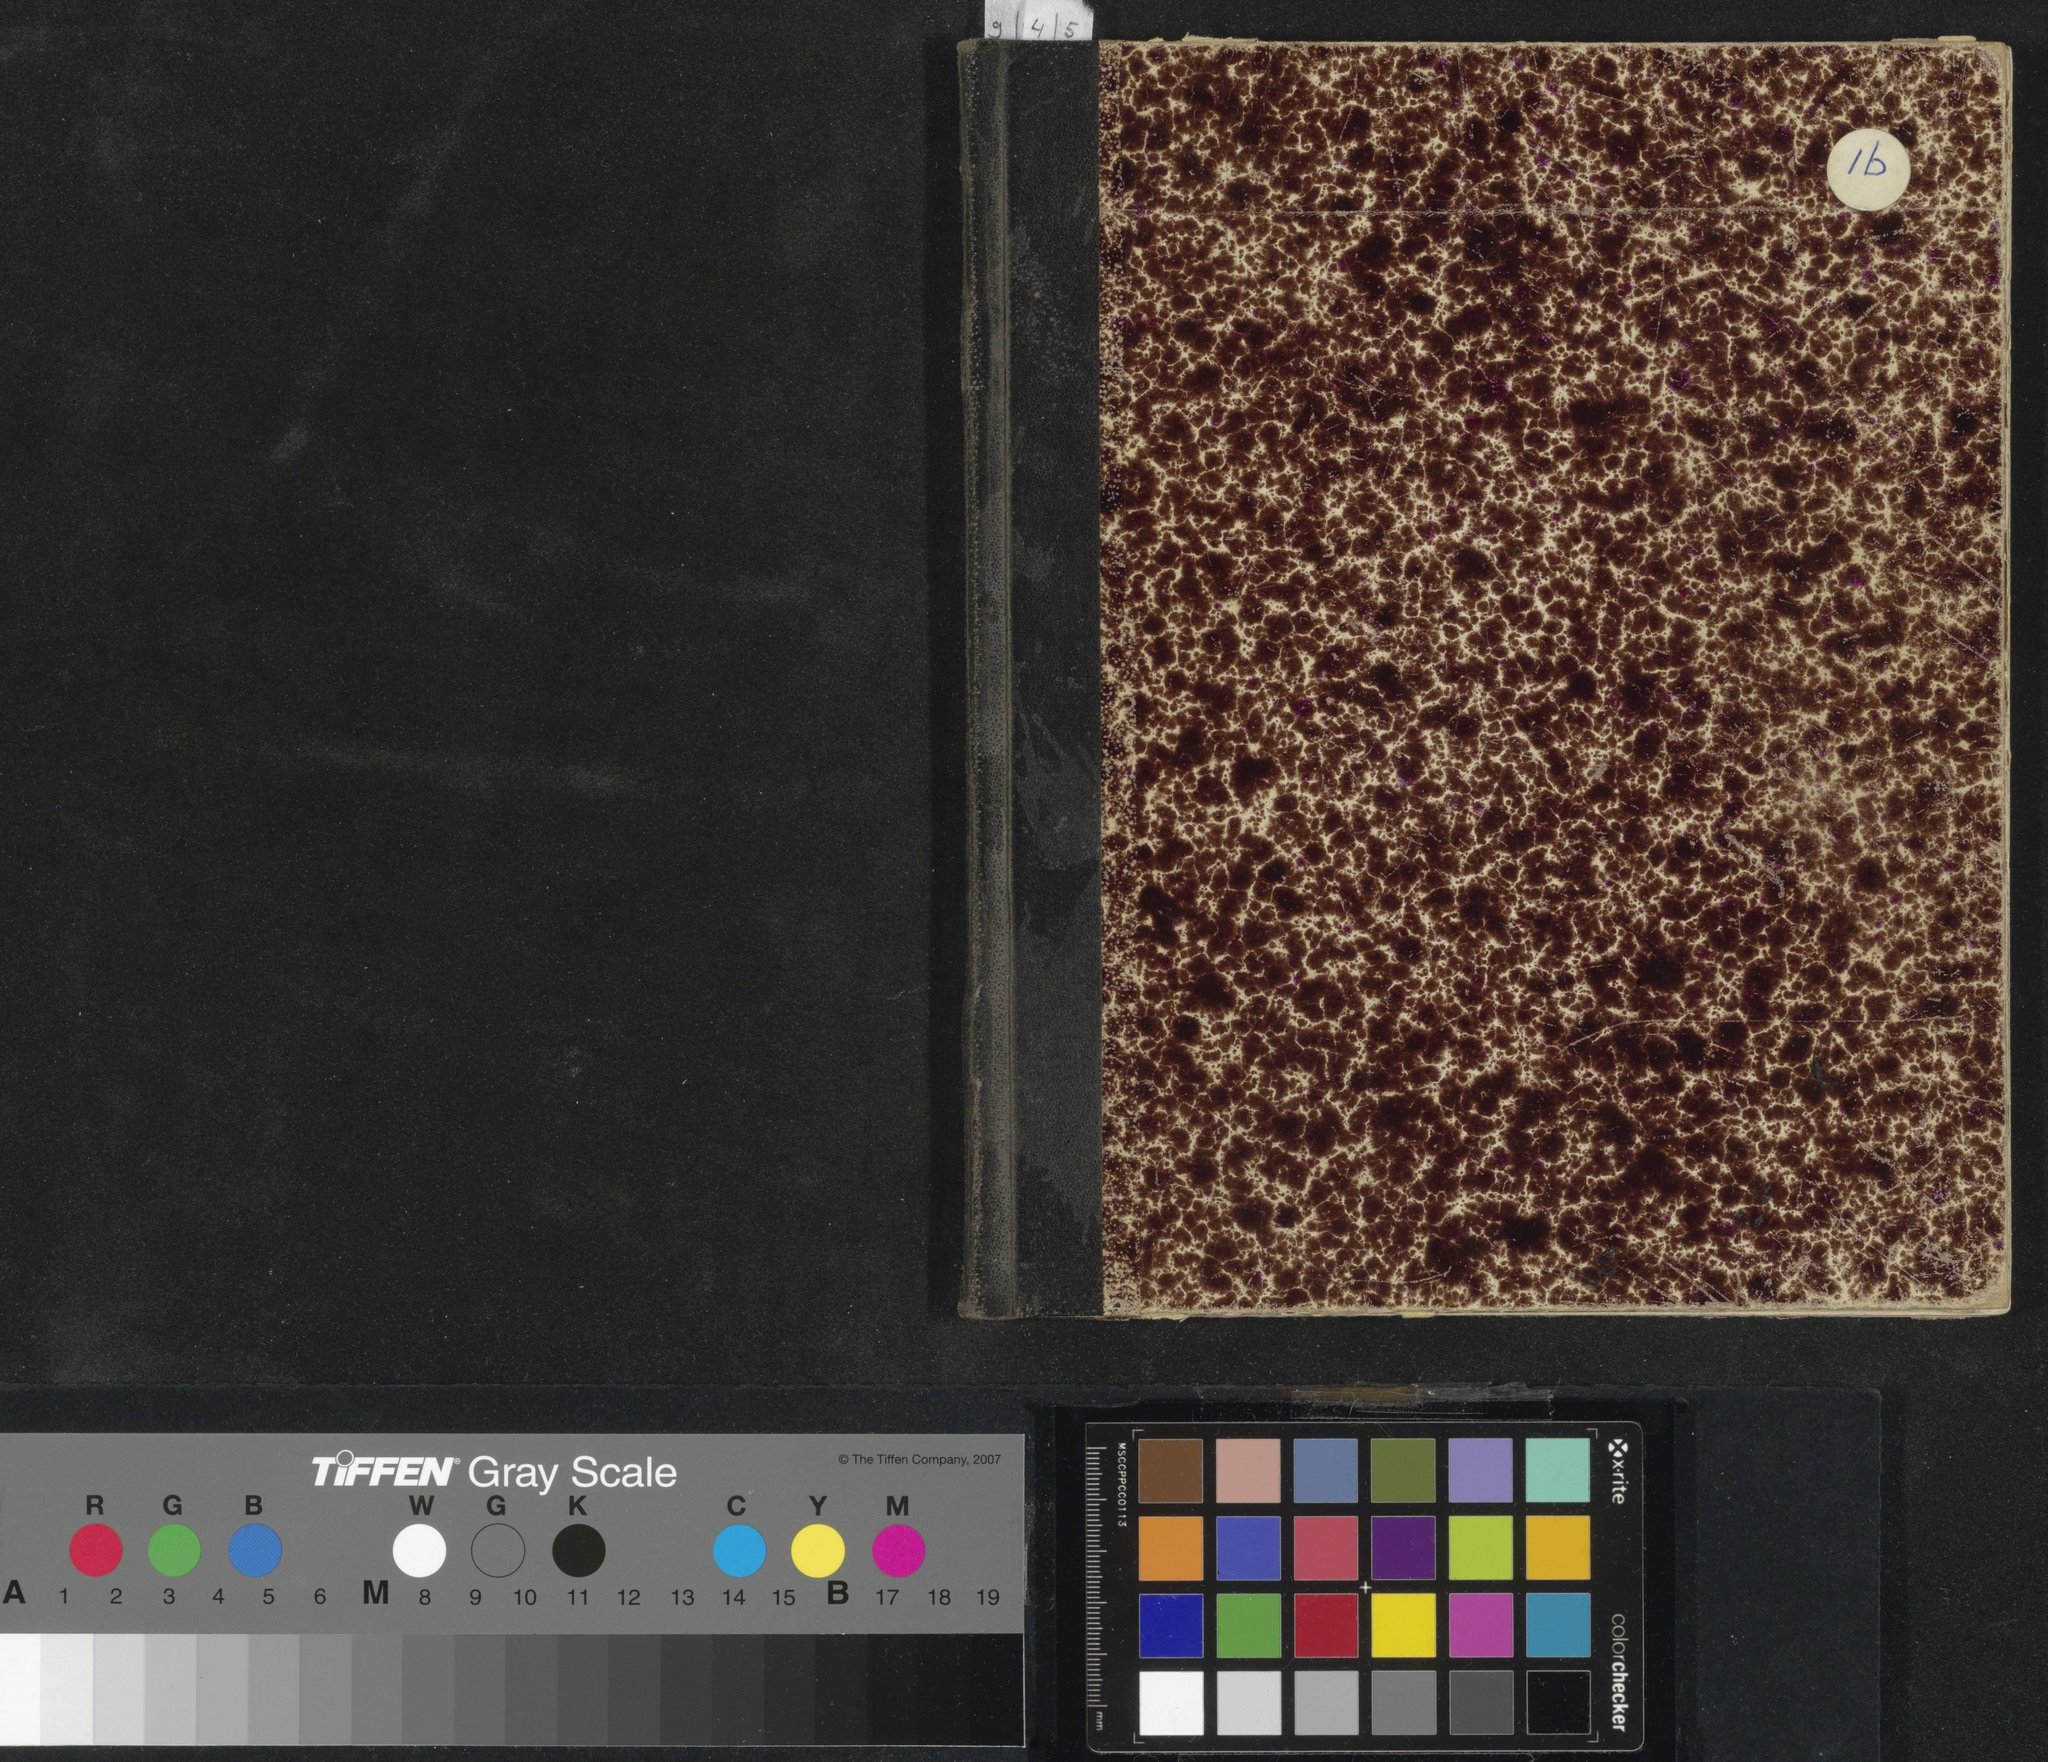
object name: sketchbook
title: Schetsboek met 15 bladen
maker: carel adolph lion cachet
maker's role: draughtsman, print maker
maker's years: 1864-1945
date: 1900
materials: cardboard, chalk, ink, linen, paper, pencil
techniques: pen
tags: furniture and household effects, architecture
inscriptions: collector's mark: Lugt 2228a, annotation: ‘Lion Cachet +- 1900’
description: Schetsboek bestaande uit 15 bladen met voornamelijk ontwerpen voor meubels en architectuurstudies.